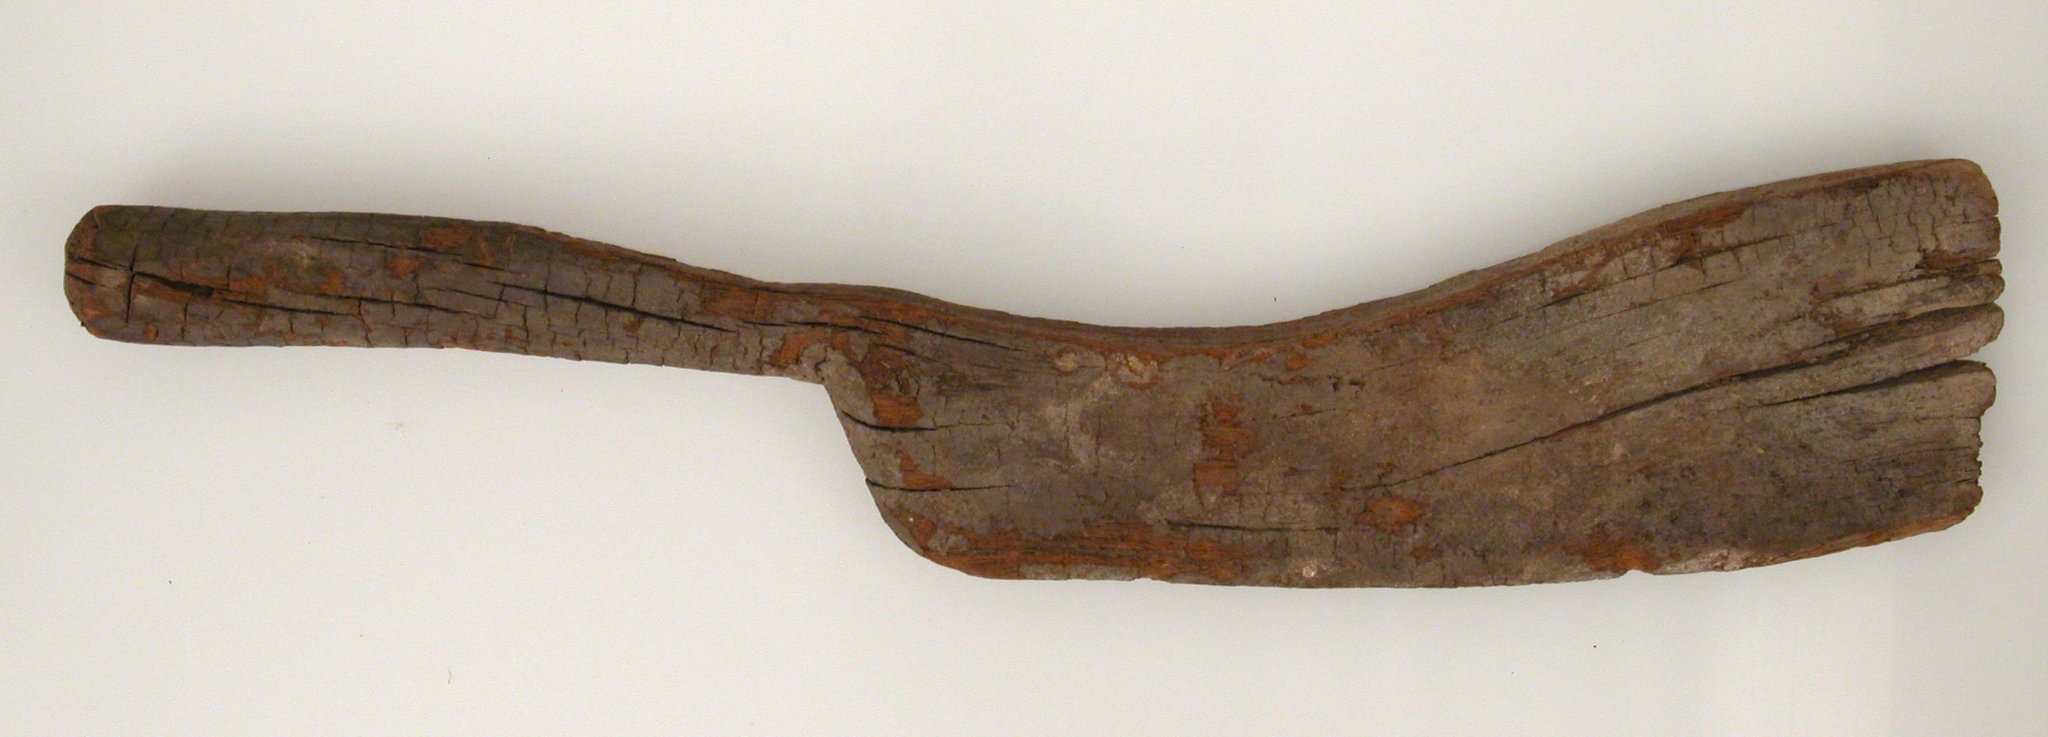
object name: scoop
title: Winnowing Scoop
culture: coptic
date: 580-640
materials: wood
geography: egypt